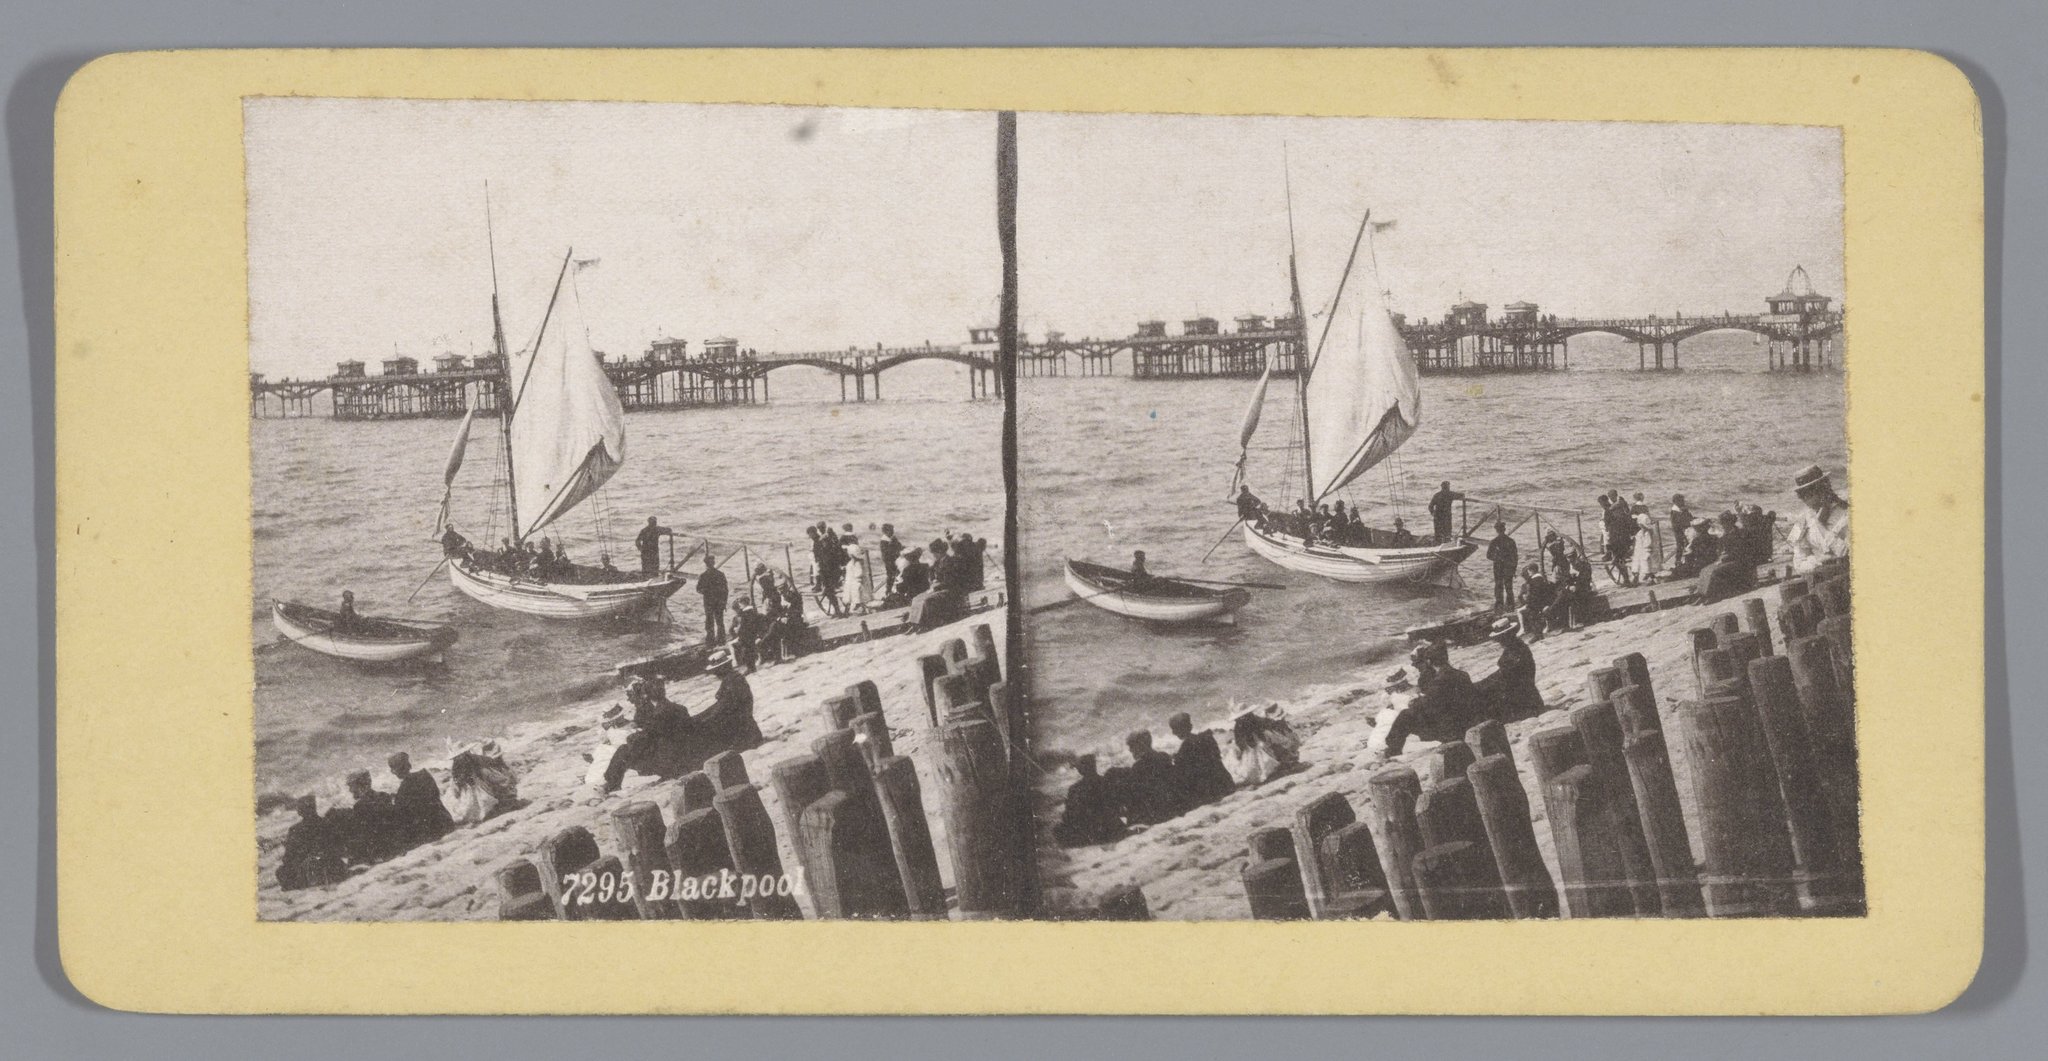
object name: stereograph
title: Blackpool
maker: Anonymous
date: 1890-1910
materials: cardboard, paper, ink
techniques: photograph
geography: blackpool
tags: ships (in general), pier, quay, wharf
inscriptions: number: ‘7295’